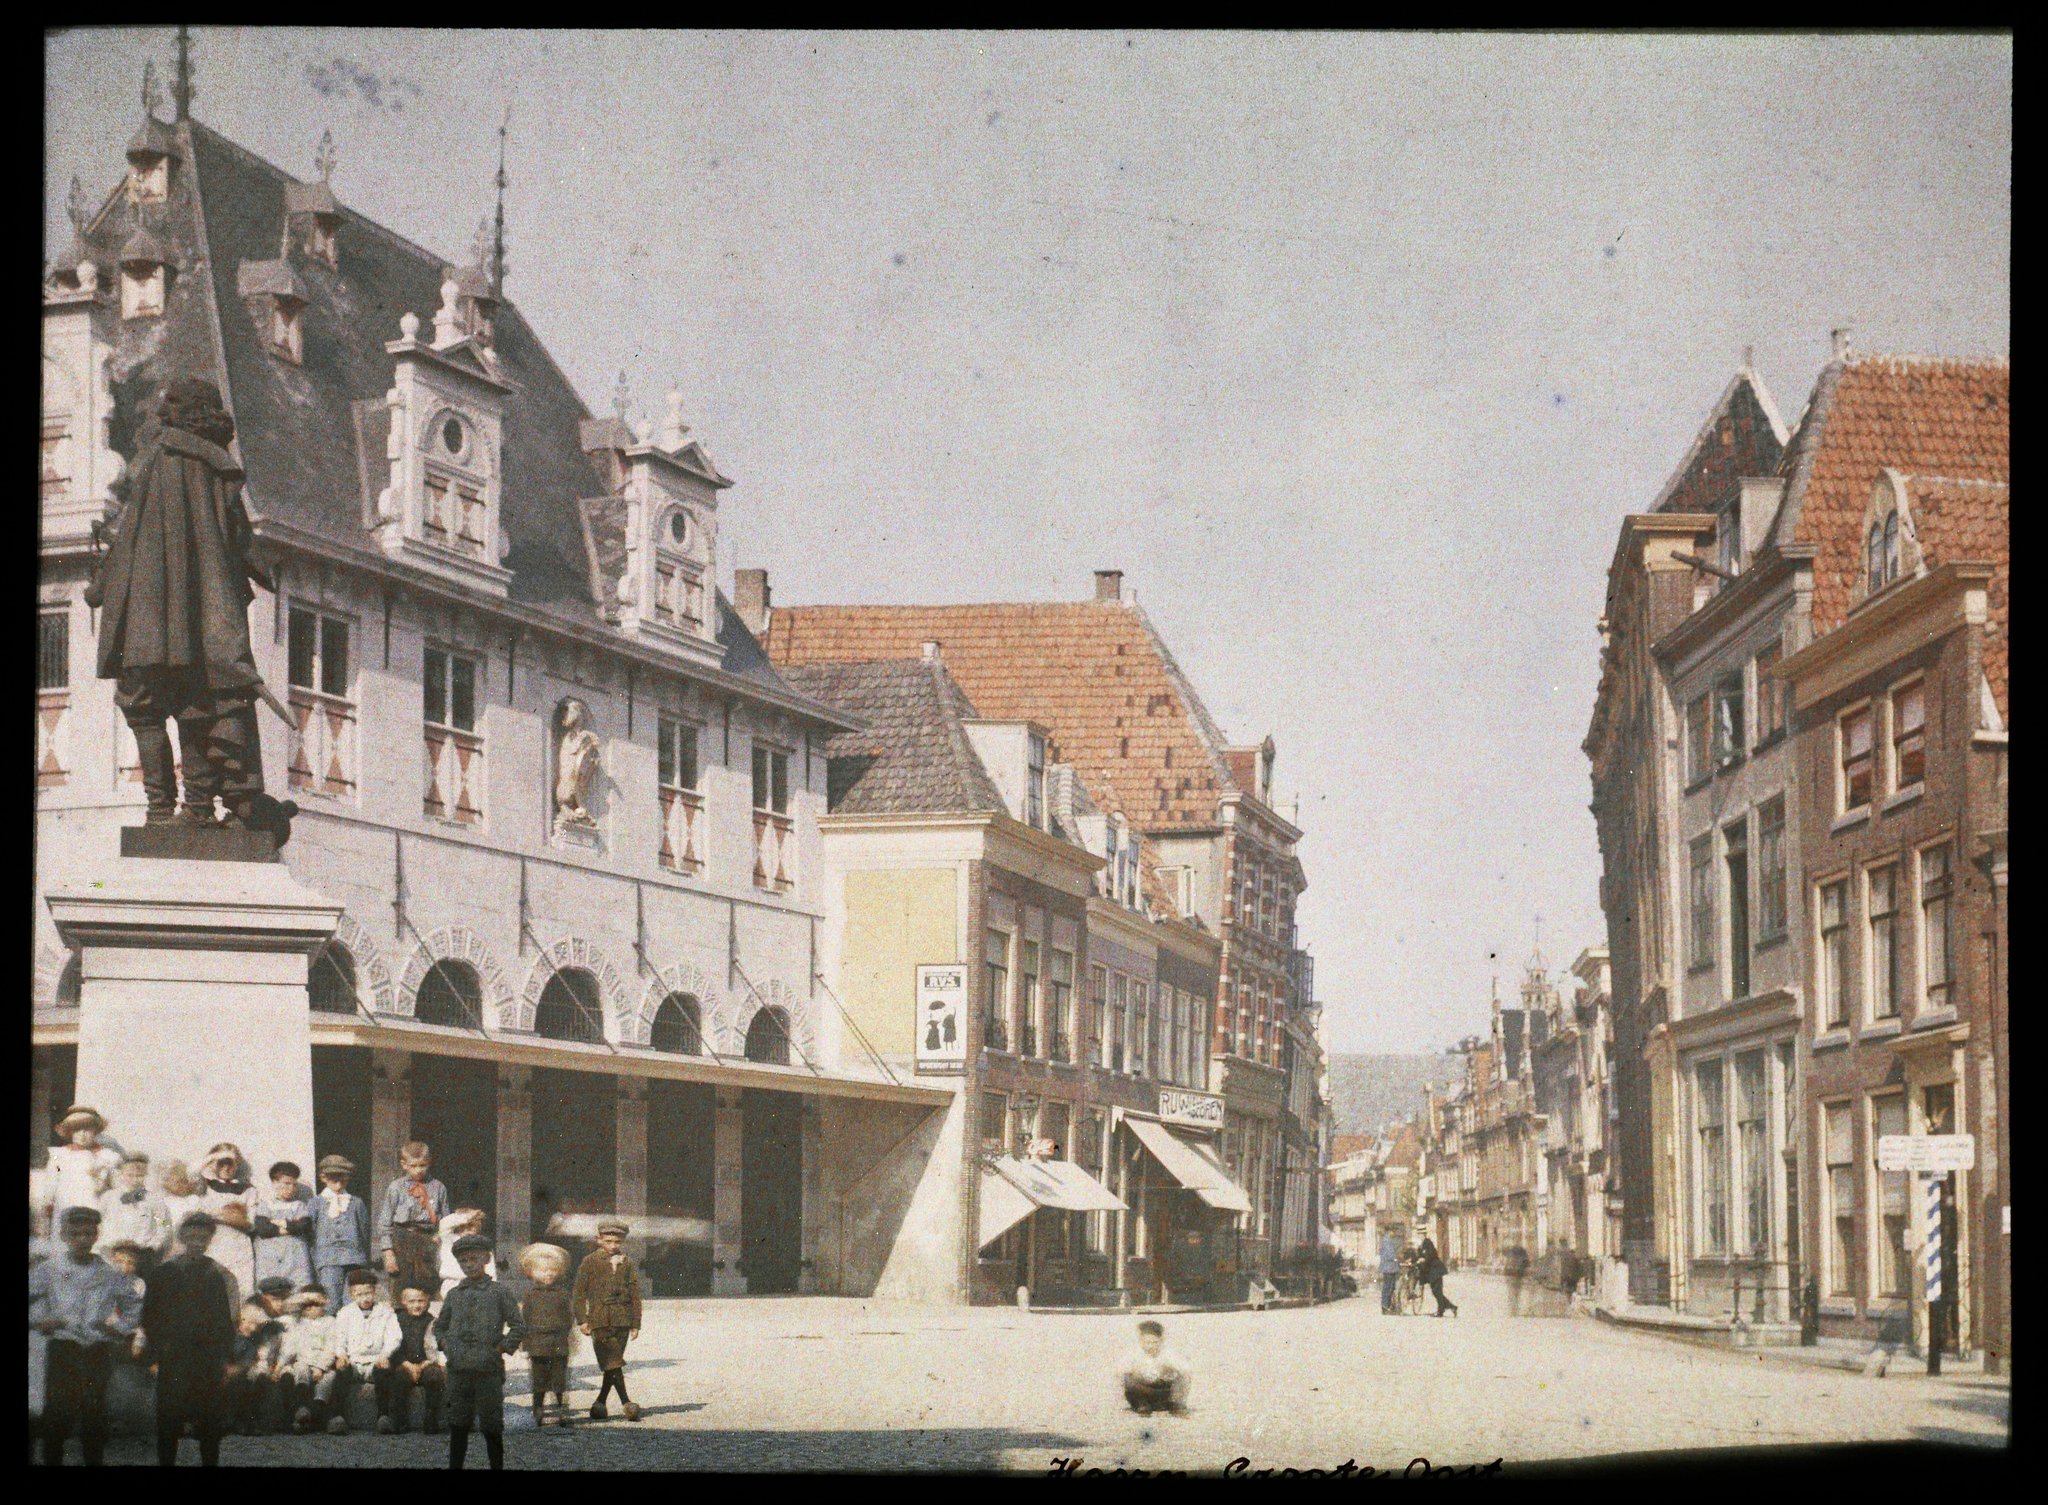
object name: glasdia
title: Gezicht op de markt van Hoorn, met het standbeeld van Jan Pietersz. Coen en de Waag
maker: Anonymous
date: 1907-1930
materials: glass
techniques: autochrome process, slide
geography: hoorn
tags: grote oost (hoorn)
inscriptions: annotation: ‘Hoorn Groote Oost’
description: Gezicht op de markt van Hoorn, met het standbeeld van Jan Pietersz. Coen (waar een groep kinderen voor poseert) en de Waag, gezien naar de Grote Oost.